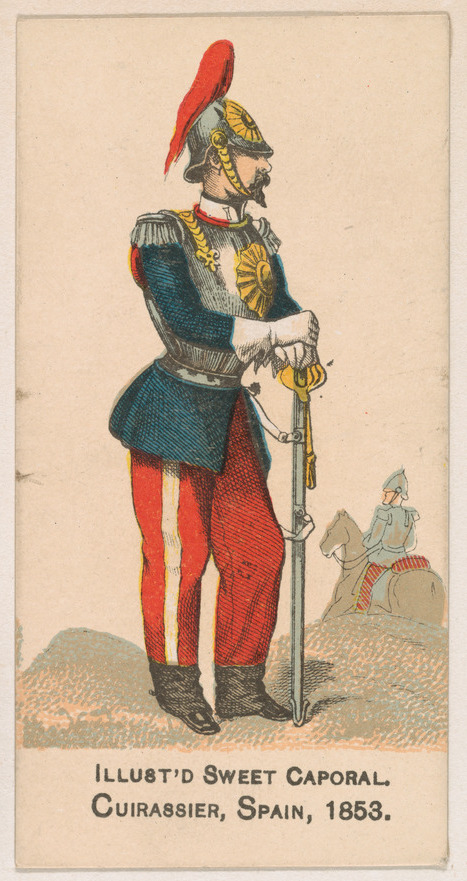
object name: print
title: Cuirassier, Spain, 1853, from the Military Series (N224) issued by Kinney Tobacco Company to promote Sweet Caporal Cigarettes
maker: kinney brothers tobacco company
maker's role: publisher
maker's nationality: american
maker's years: 1869-2011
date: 1888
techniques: color lithograph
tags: military,swords,men,profiles